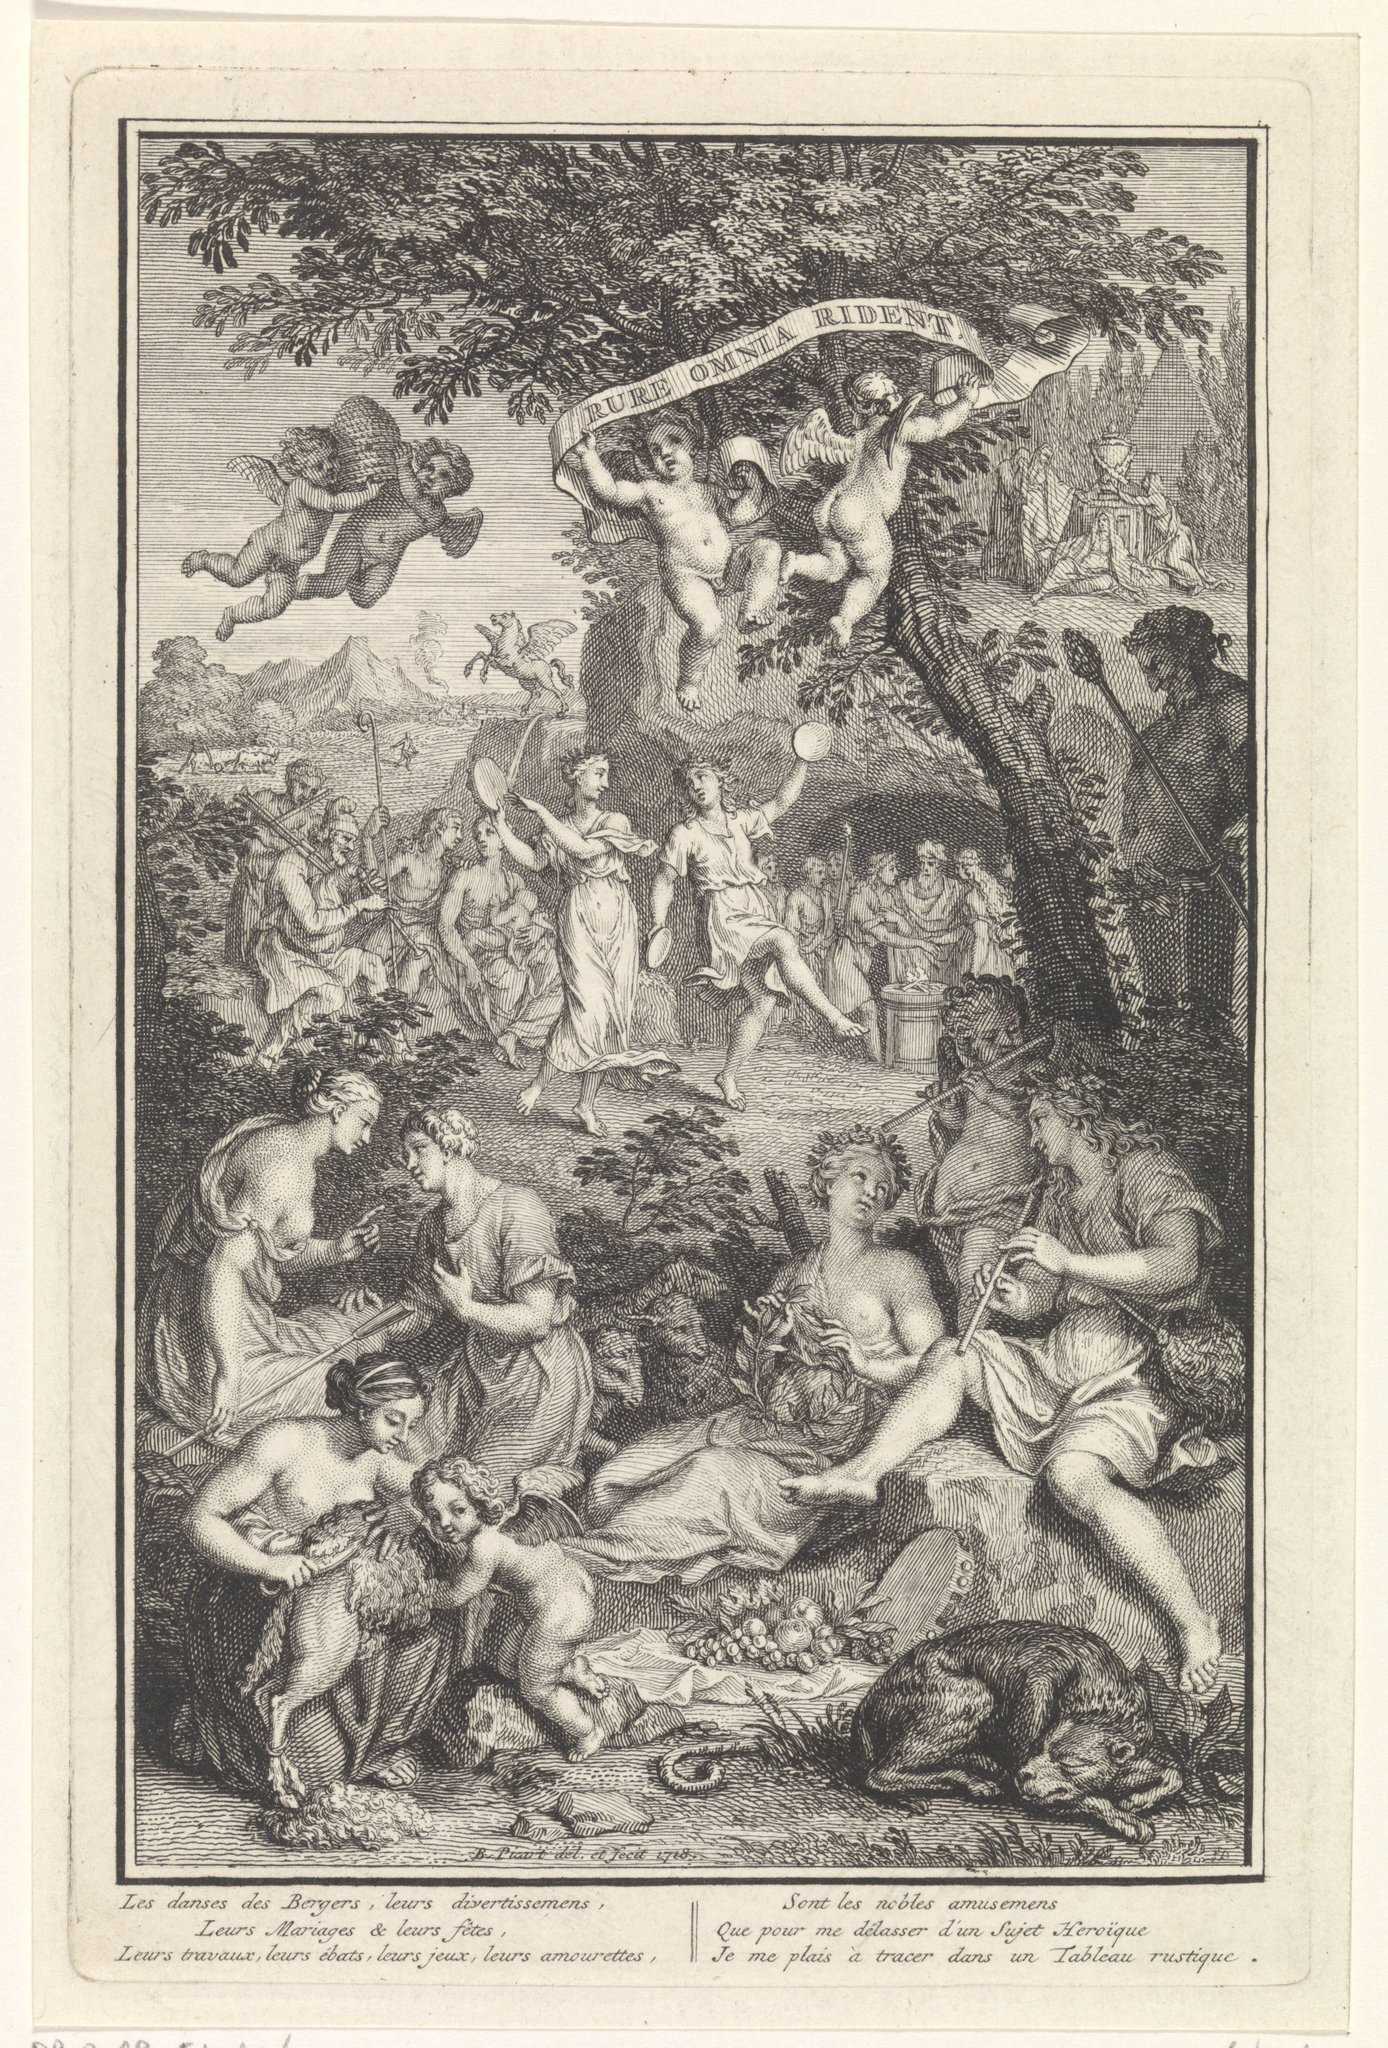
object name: print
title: Landschap met herders en herderinnen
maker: bernard picart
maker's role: draughtsman, print maker, publisher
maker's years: 1673-1733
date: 1718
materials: paper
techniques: engraving, etching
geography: amsterdam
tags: honey-comb, pegasus, the winged horse, making music; musician with instrument, dancing, grave, tomb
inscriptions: collector's mark: Lugt 240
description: Allegorische voorstelling met herders en herderinnen in een landschap. Zij maken muziek, dansen, trouwen, en bewerken het land. Links op de achtergrond Pegasus. Rechts op de achtergrond treurende vrouwen rond een grafmonument. In de lucht twee putti met een bijenkorf (een symbool van welsprekendheid) en twee putti met een banderol waarop een devies in het Latijn. In de marge een zesregelig gedicht, in twee kolommen, in het Frans.